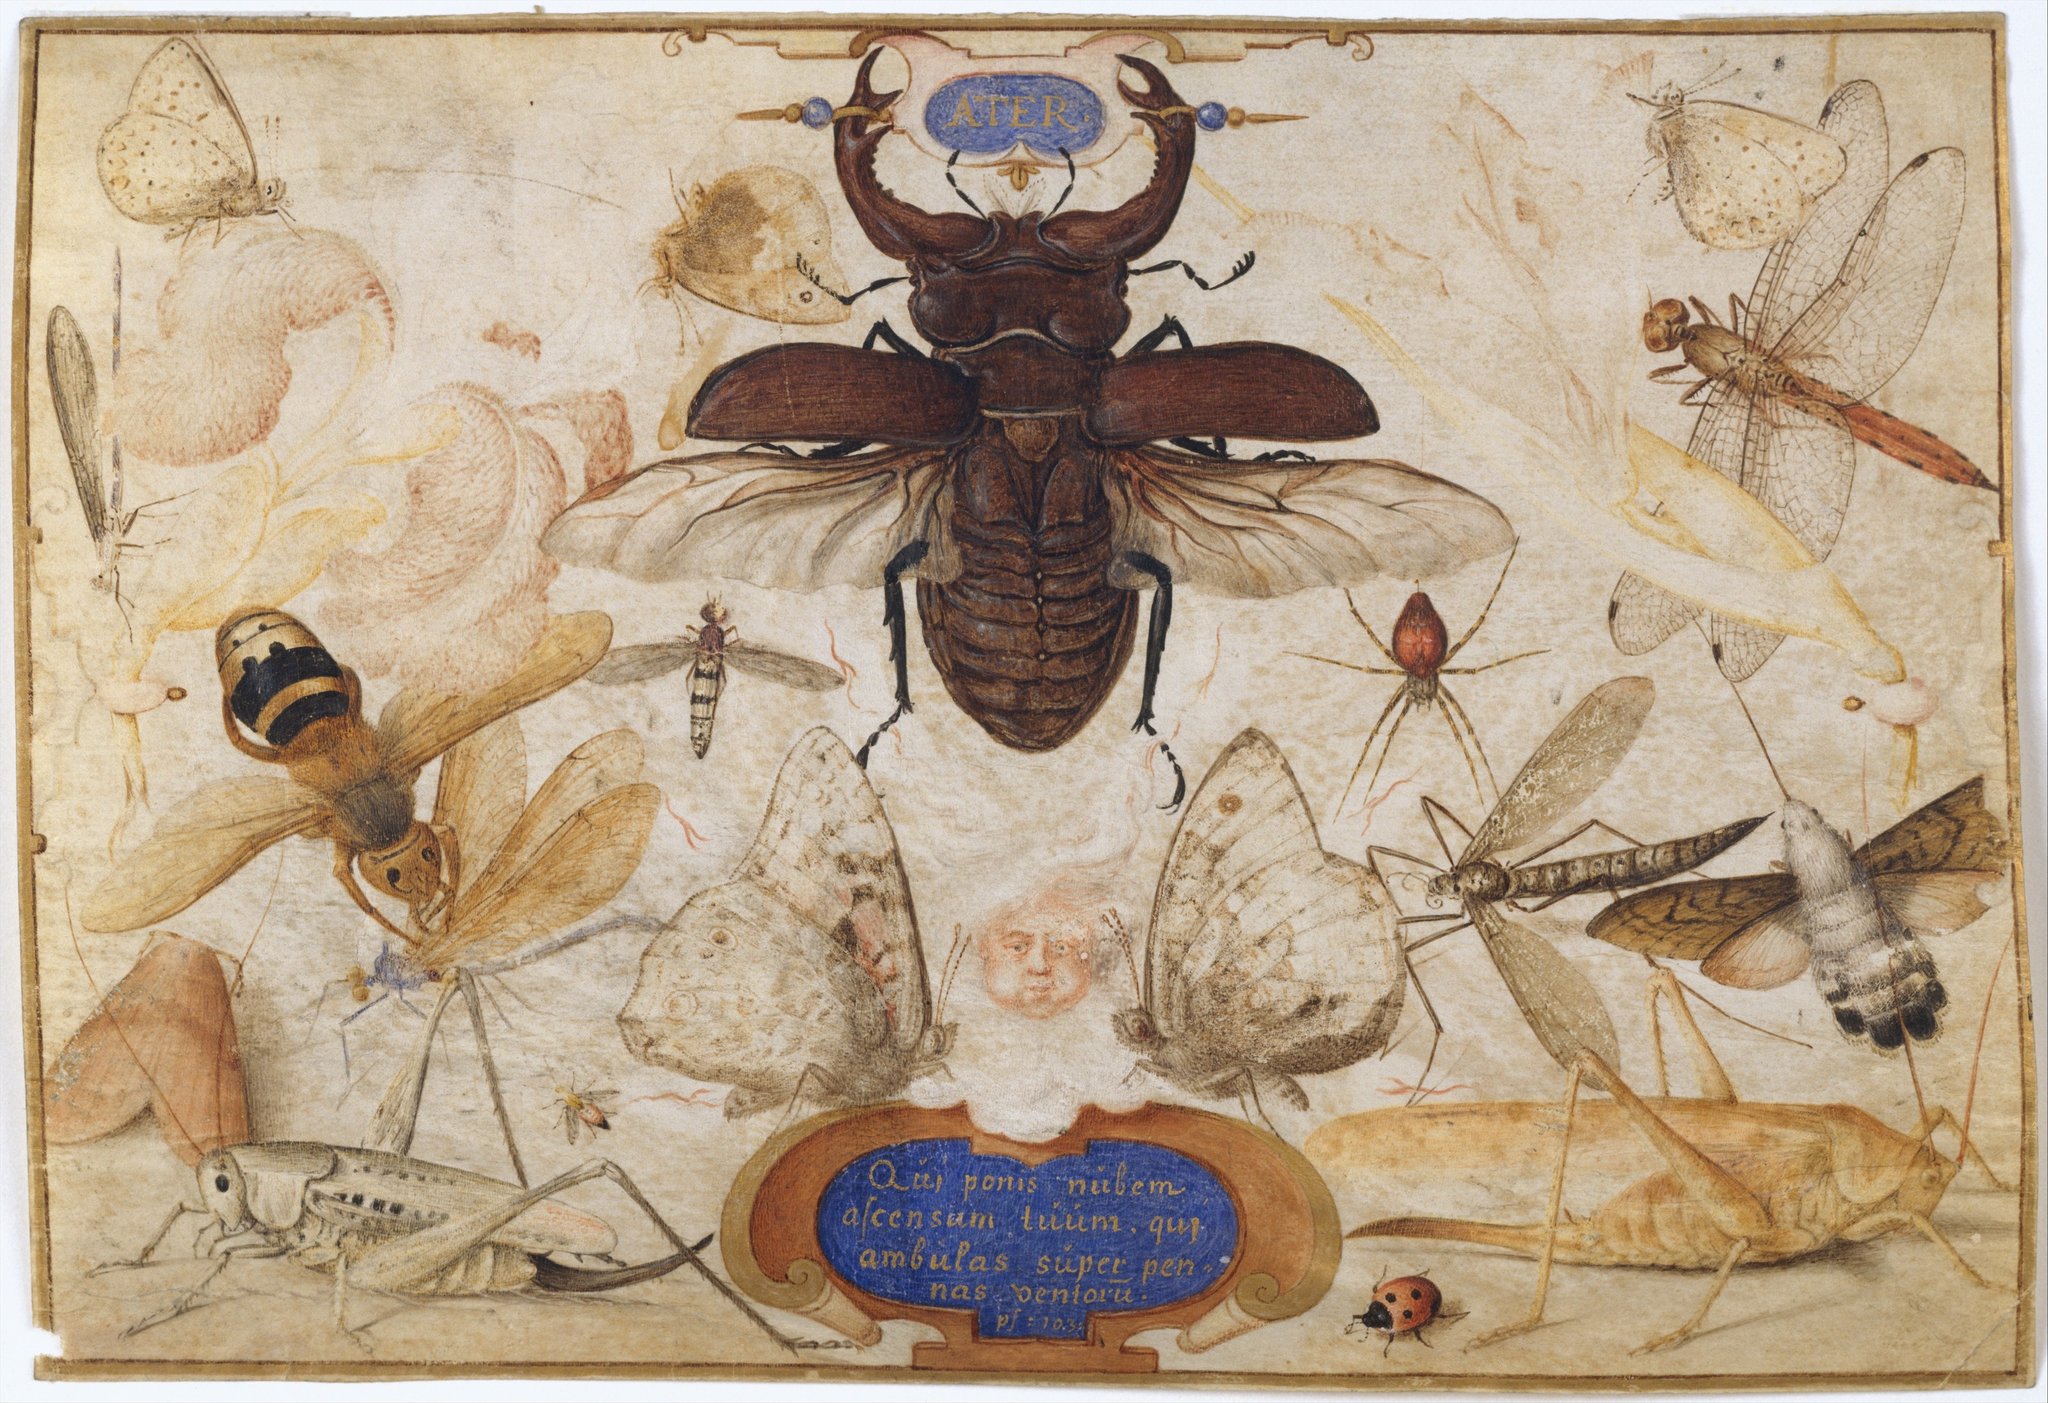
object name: drawing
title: Insects and the Head of a Wind God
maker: joris hoefnagel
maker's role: artist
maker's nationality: netherlandish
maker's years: 1542-1600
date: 1590-1600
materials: gold paint, ink, parchment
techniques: pen, wash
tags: insects,butterflies,dragonflies